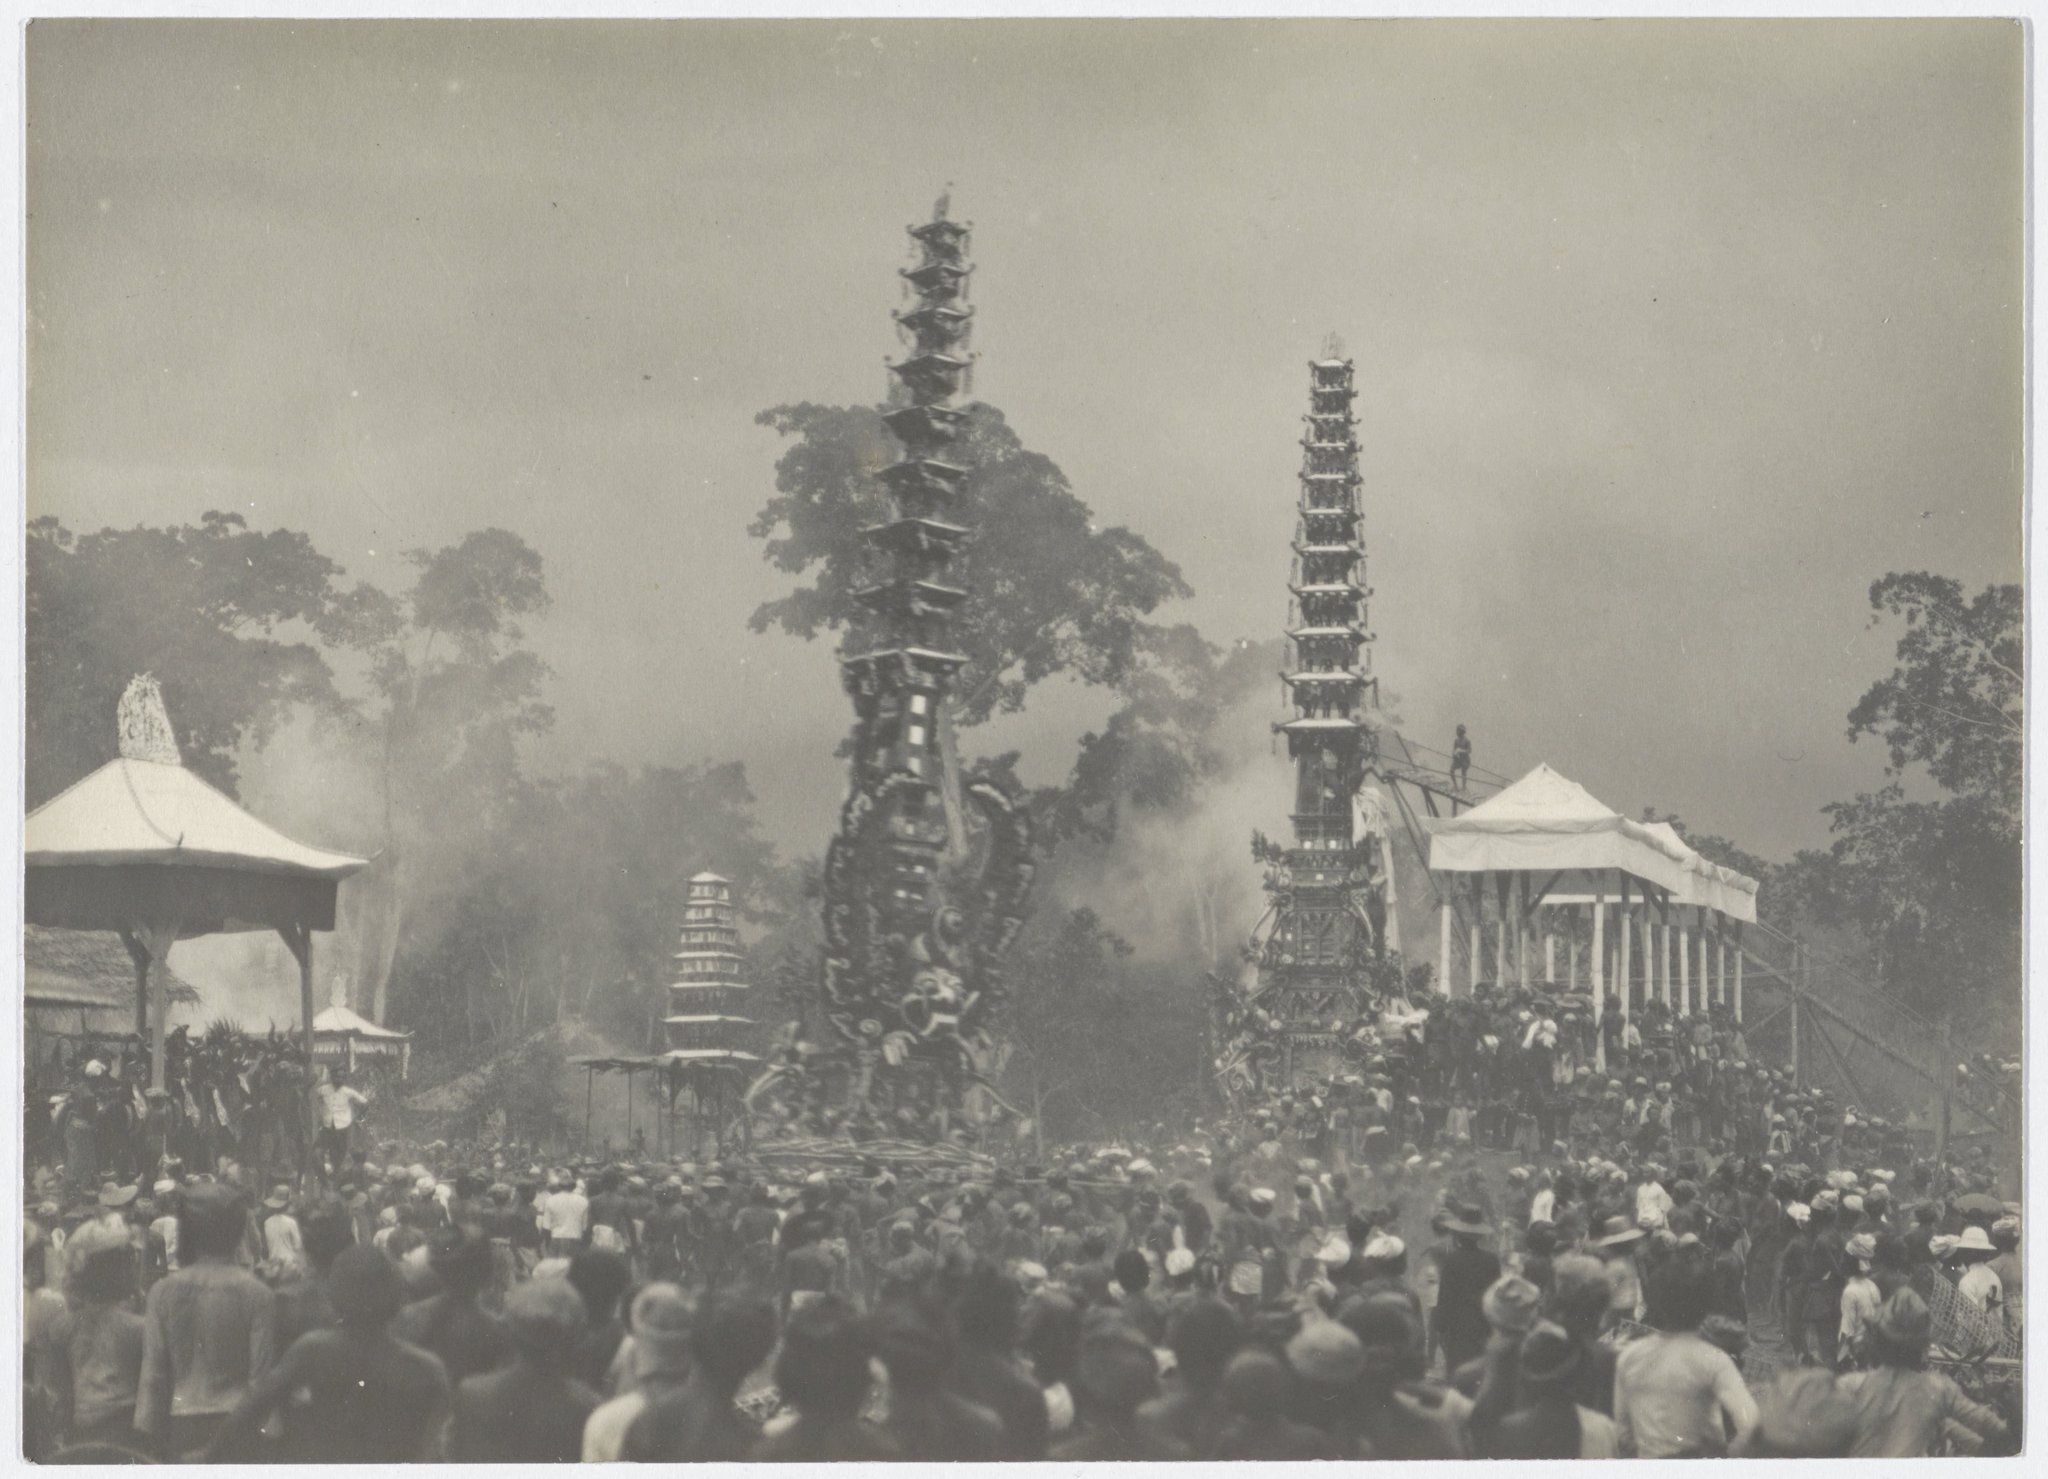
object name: photograph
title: Ceremonie lijkverbranding.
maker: Anonymous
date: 1890-1915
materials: cardboard, paper, photographic support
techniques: albumen print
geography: indonesia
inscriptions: title: ‘Ceremonie lijkverbranding.’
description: Ceremoniële crematie op Bali waarbij de lichamen worden verbrand in zelfgebouwde houten torens.